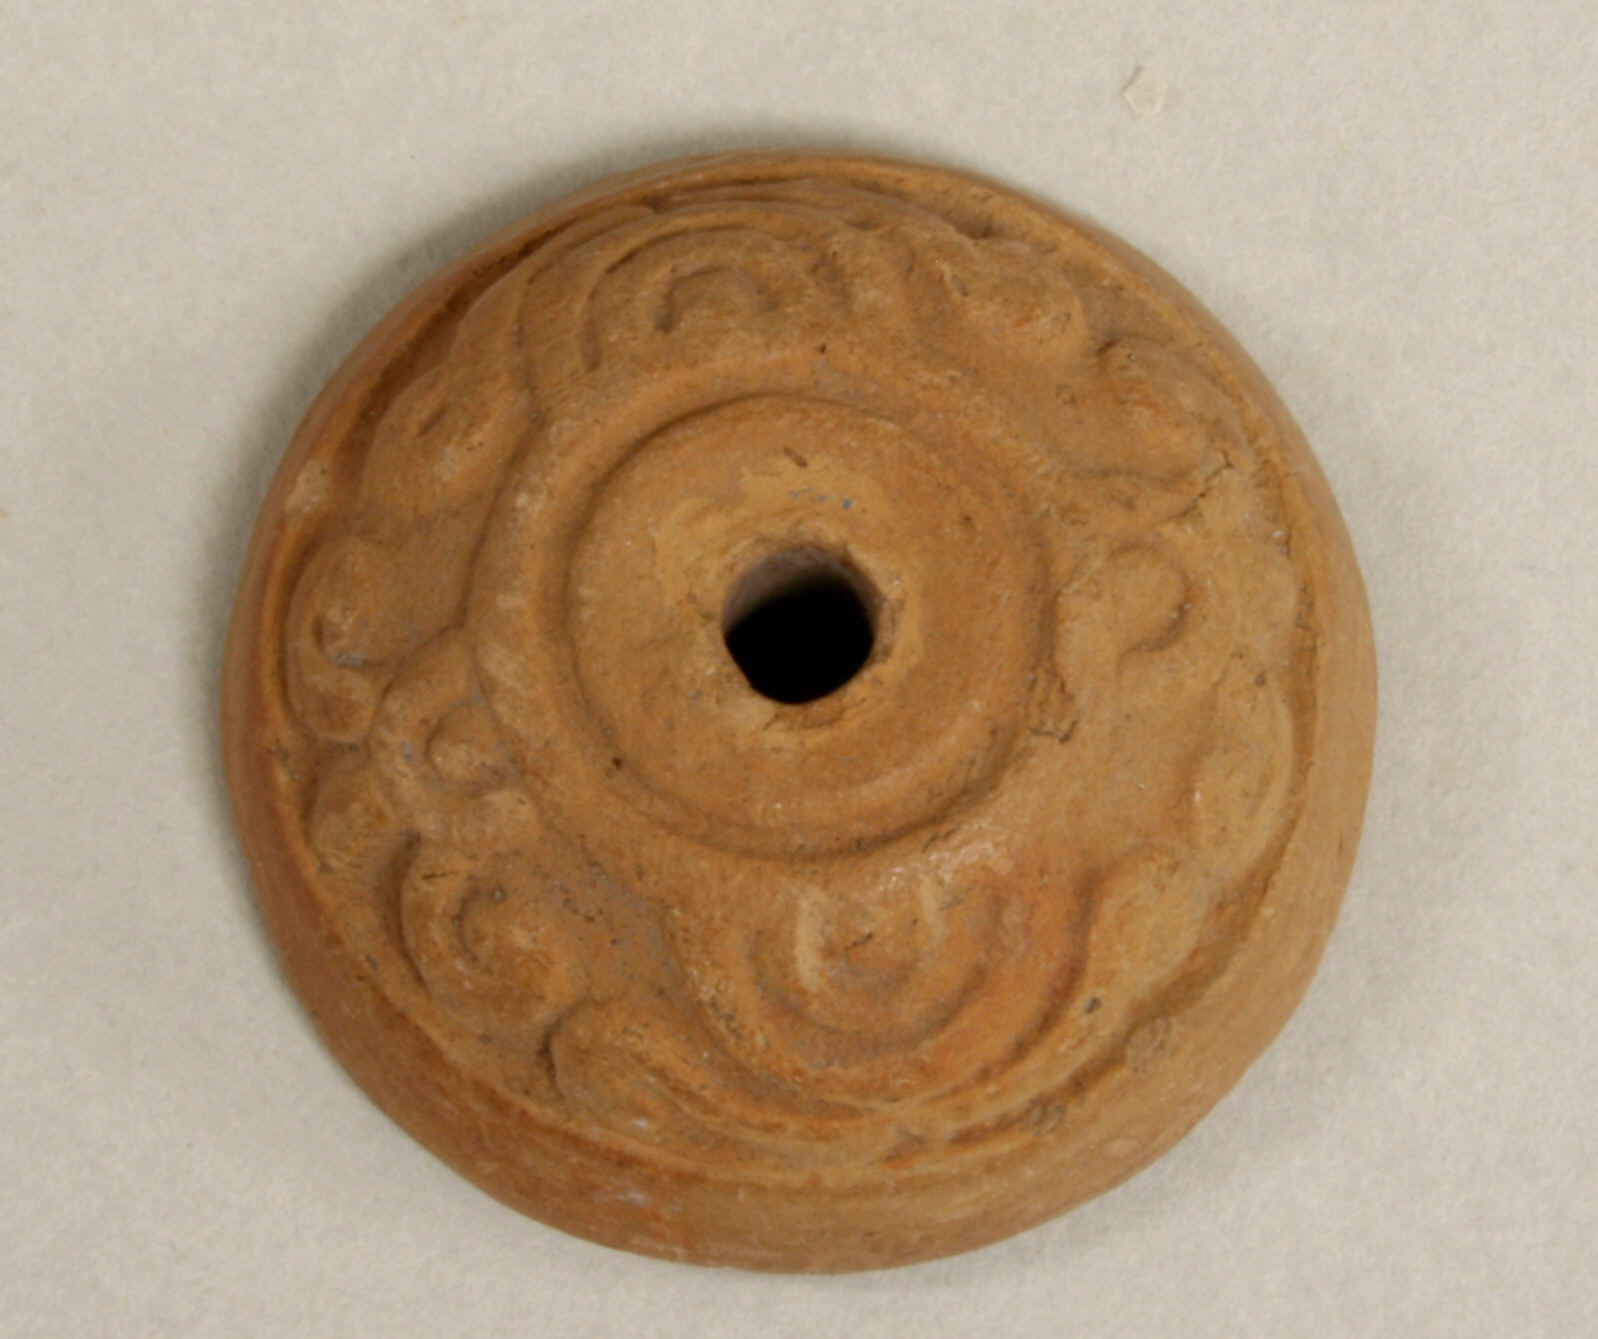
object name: spindle whorl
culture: mexican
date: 801-1500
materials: ceramic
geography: mexico